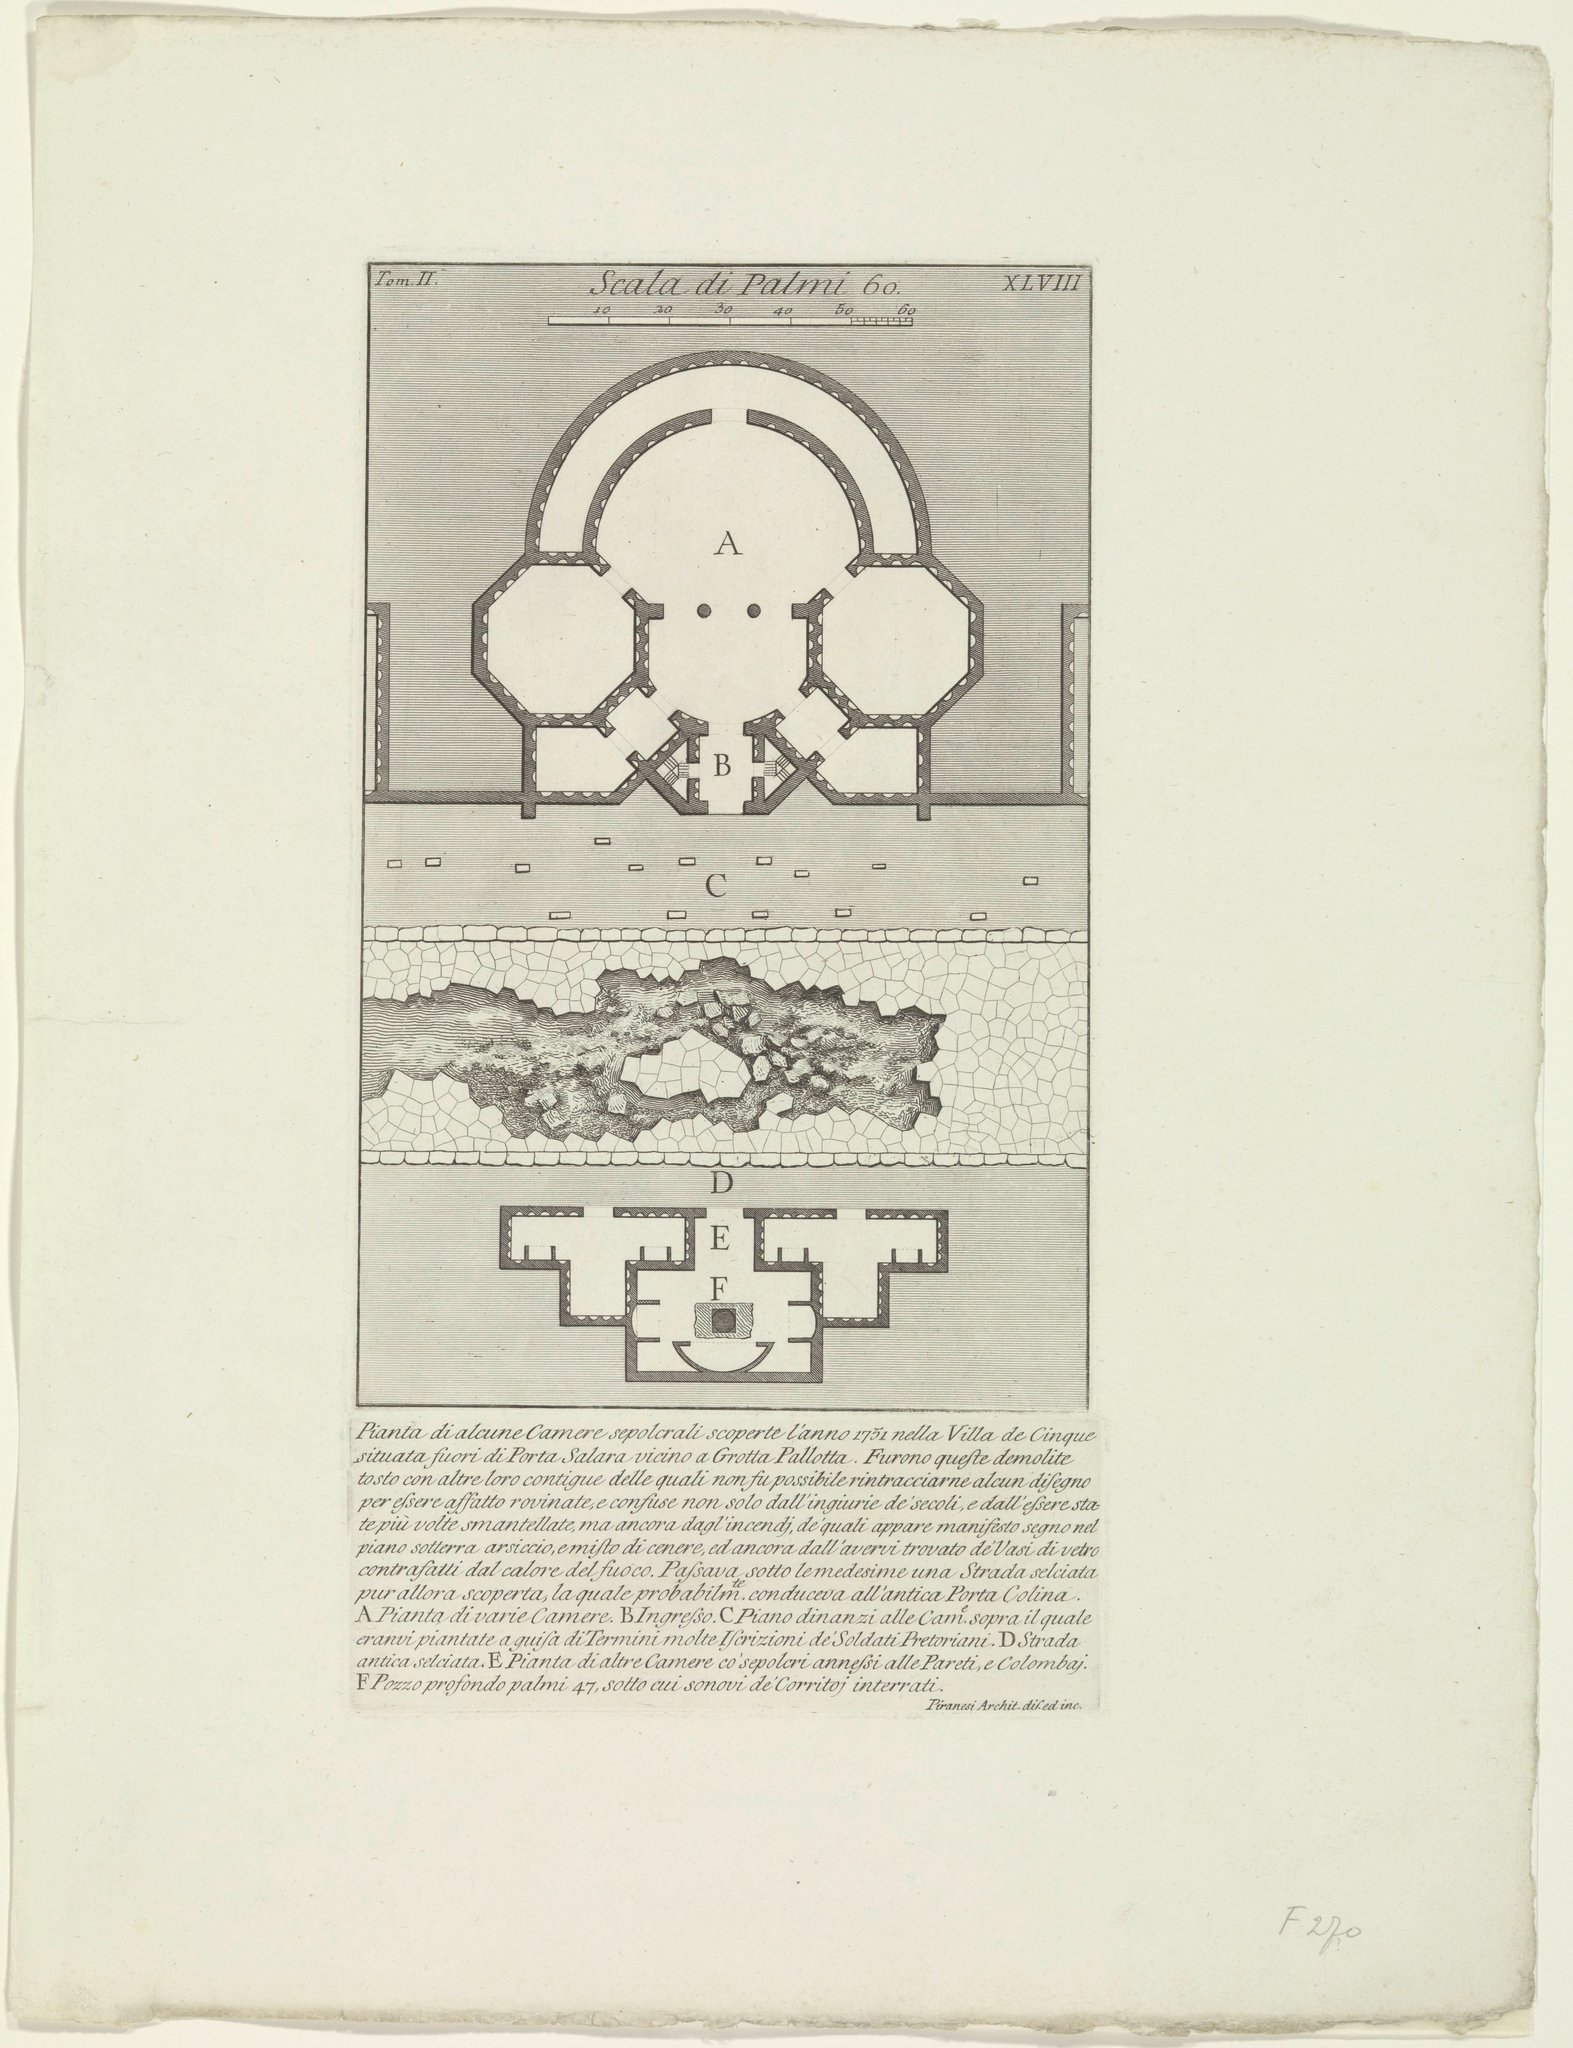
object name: print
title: Graftombe in de Villa de' Cinque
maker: giovanni battista piranesi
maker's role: designer, draughtsman, print maker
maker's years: 1720-1778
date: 1756-1757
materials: paper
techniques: etching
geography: rome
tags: grave, tomb, plan ~ architecture, italy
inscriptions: collector's mark: Lugt 2228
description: Deze prent maakt deel uit van de serie 'Le Antichità Romane'. Piranesi deed meer dan acht jaar voorstudie voor deze 250 platen tellende serie die in vier volumes werd uitgegeven. Hij produceerde de prenten tussen ca. 1756 en 1757. De serie bevat ook prenten door of naar andere prentmakers, onder wie Francesco Bianchini en Girolamo Rossi.